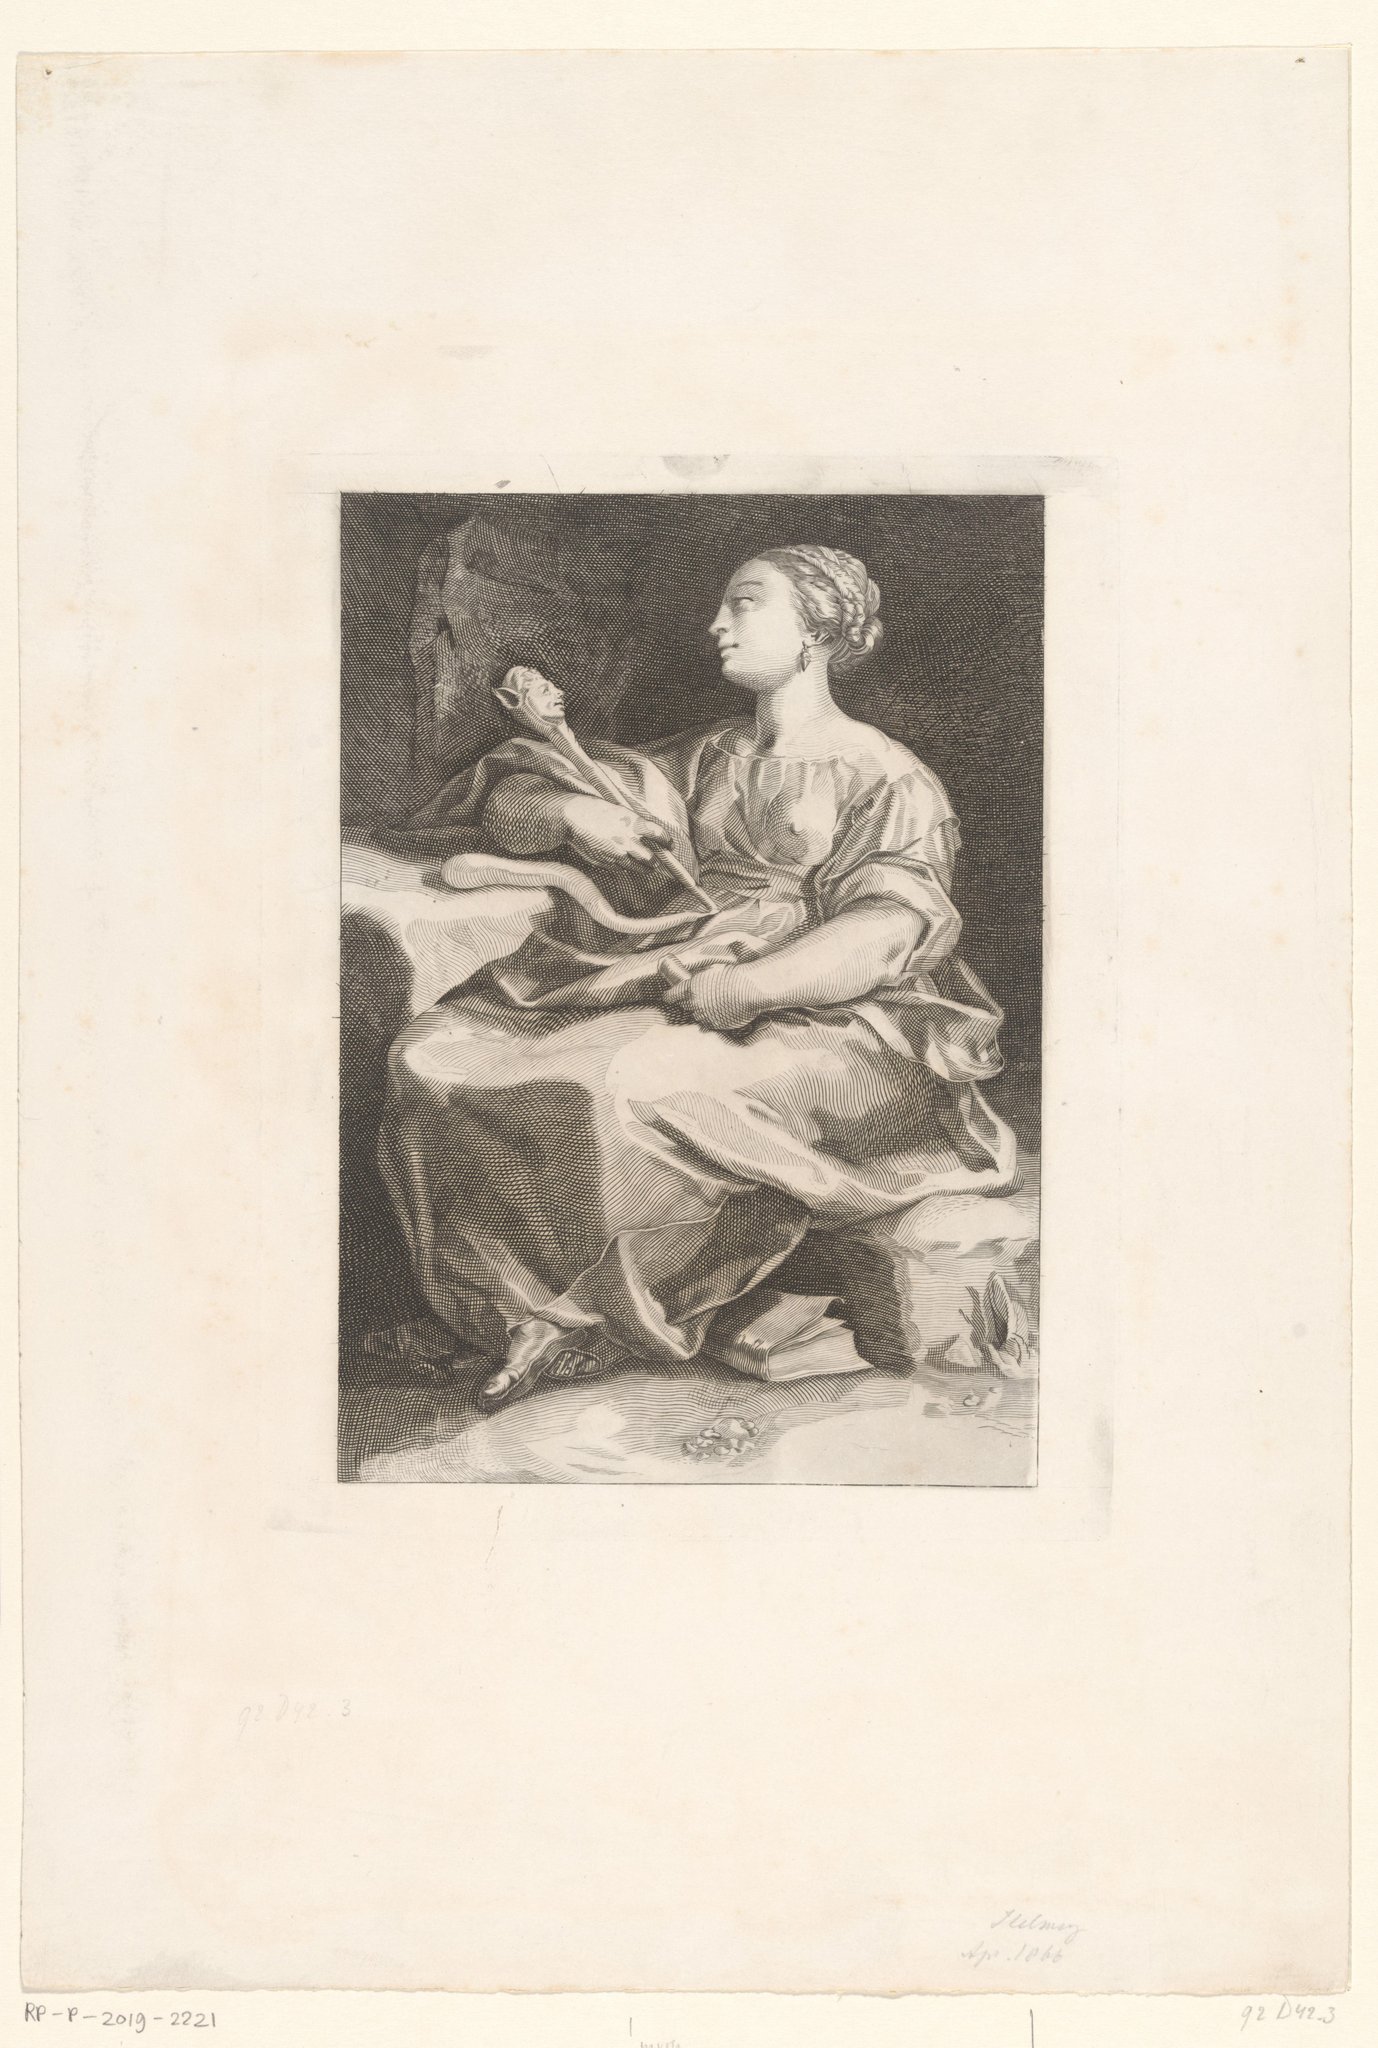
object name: print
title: Thalia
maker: carel hendrik helweg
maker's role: draughtsman, print maker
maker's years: 1846-1903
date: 1866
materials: paper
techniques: engraving, intaglio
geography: amsterdam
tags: thalia (one of the muses); 'talia' (ripa)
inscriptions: collector's mark: Lugt 2228, inscription: ‘Helweg/ Apr. 1866’